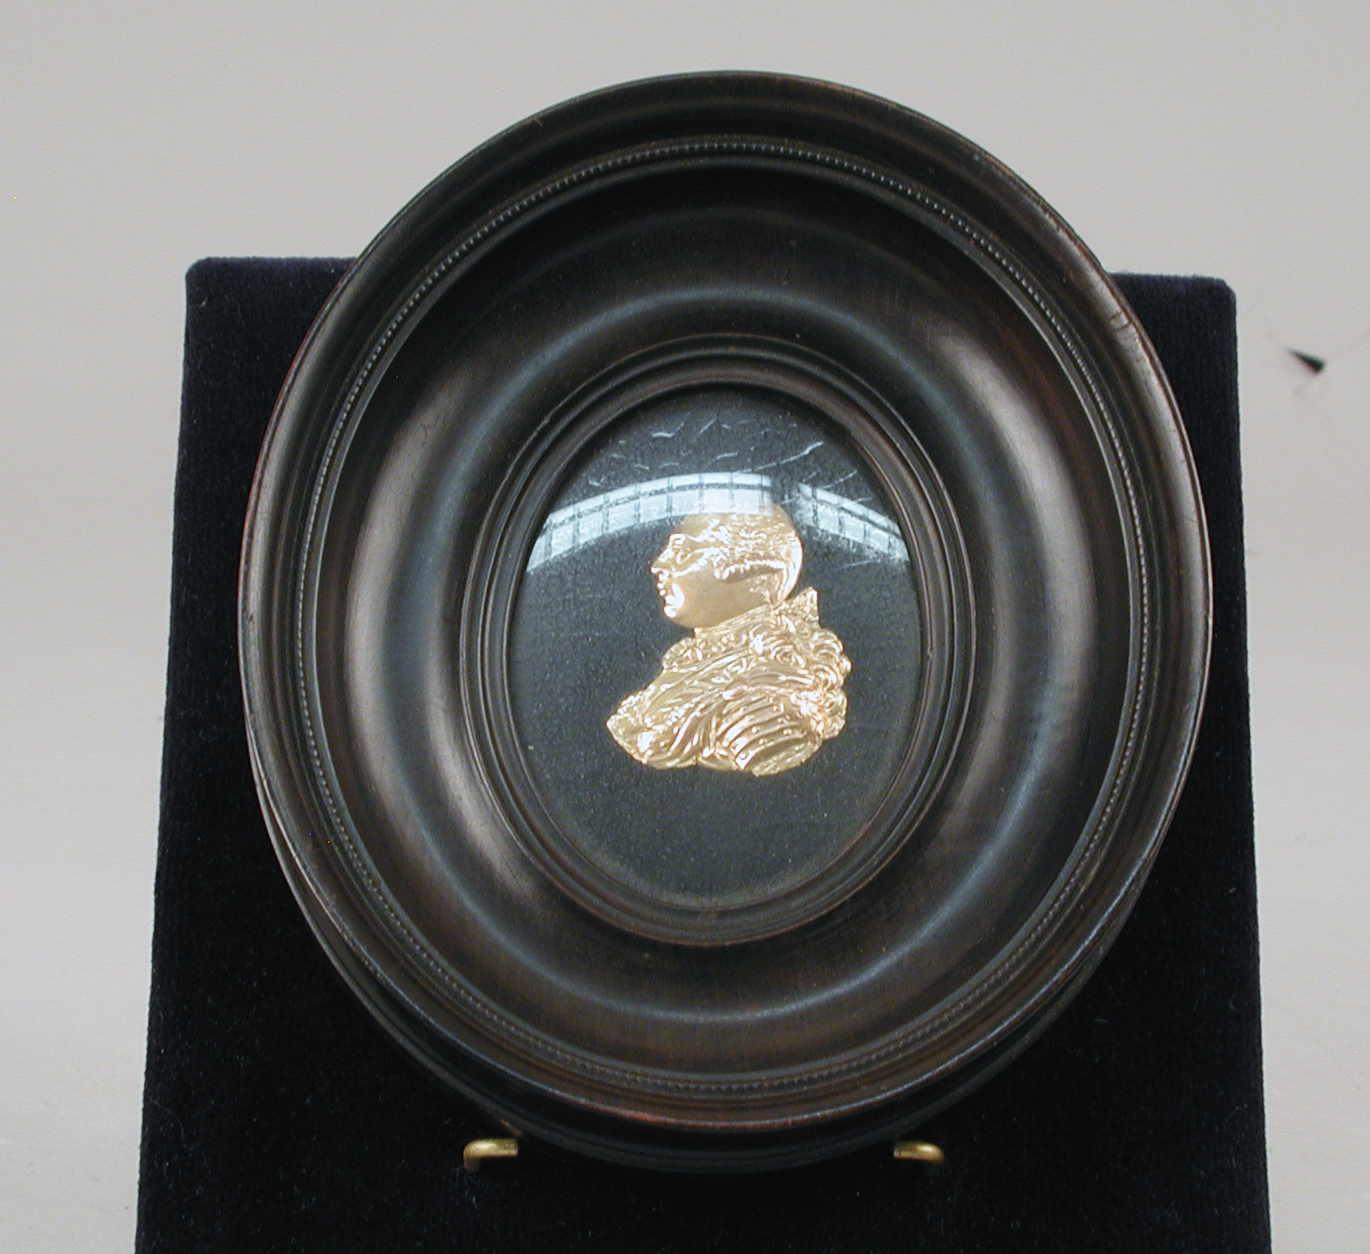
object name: medallion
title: George III (1738–1820)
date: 1801-1900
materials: copper gilt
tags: men,profiles